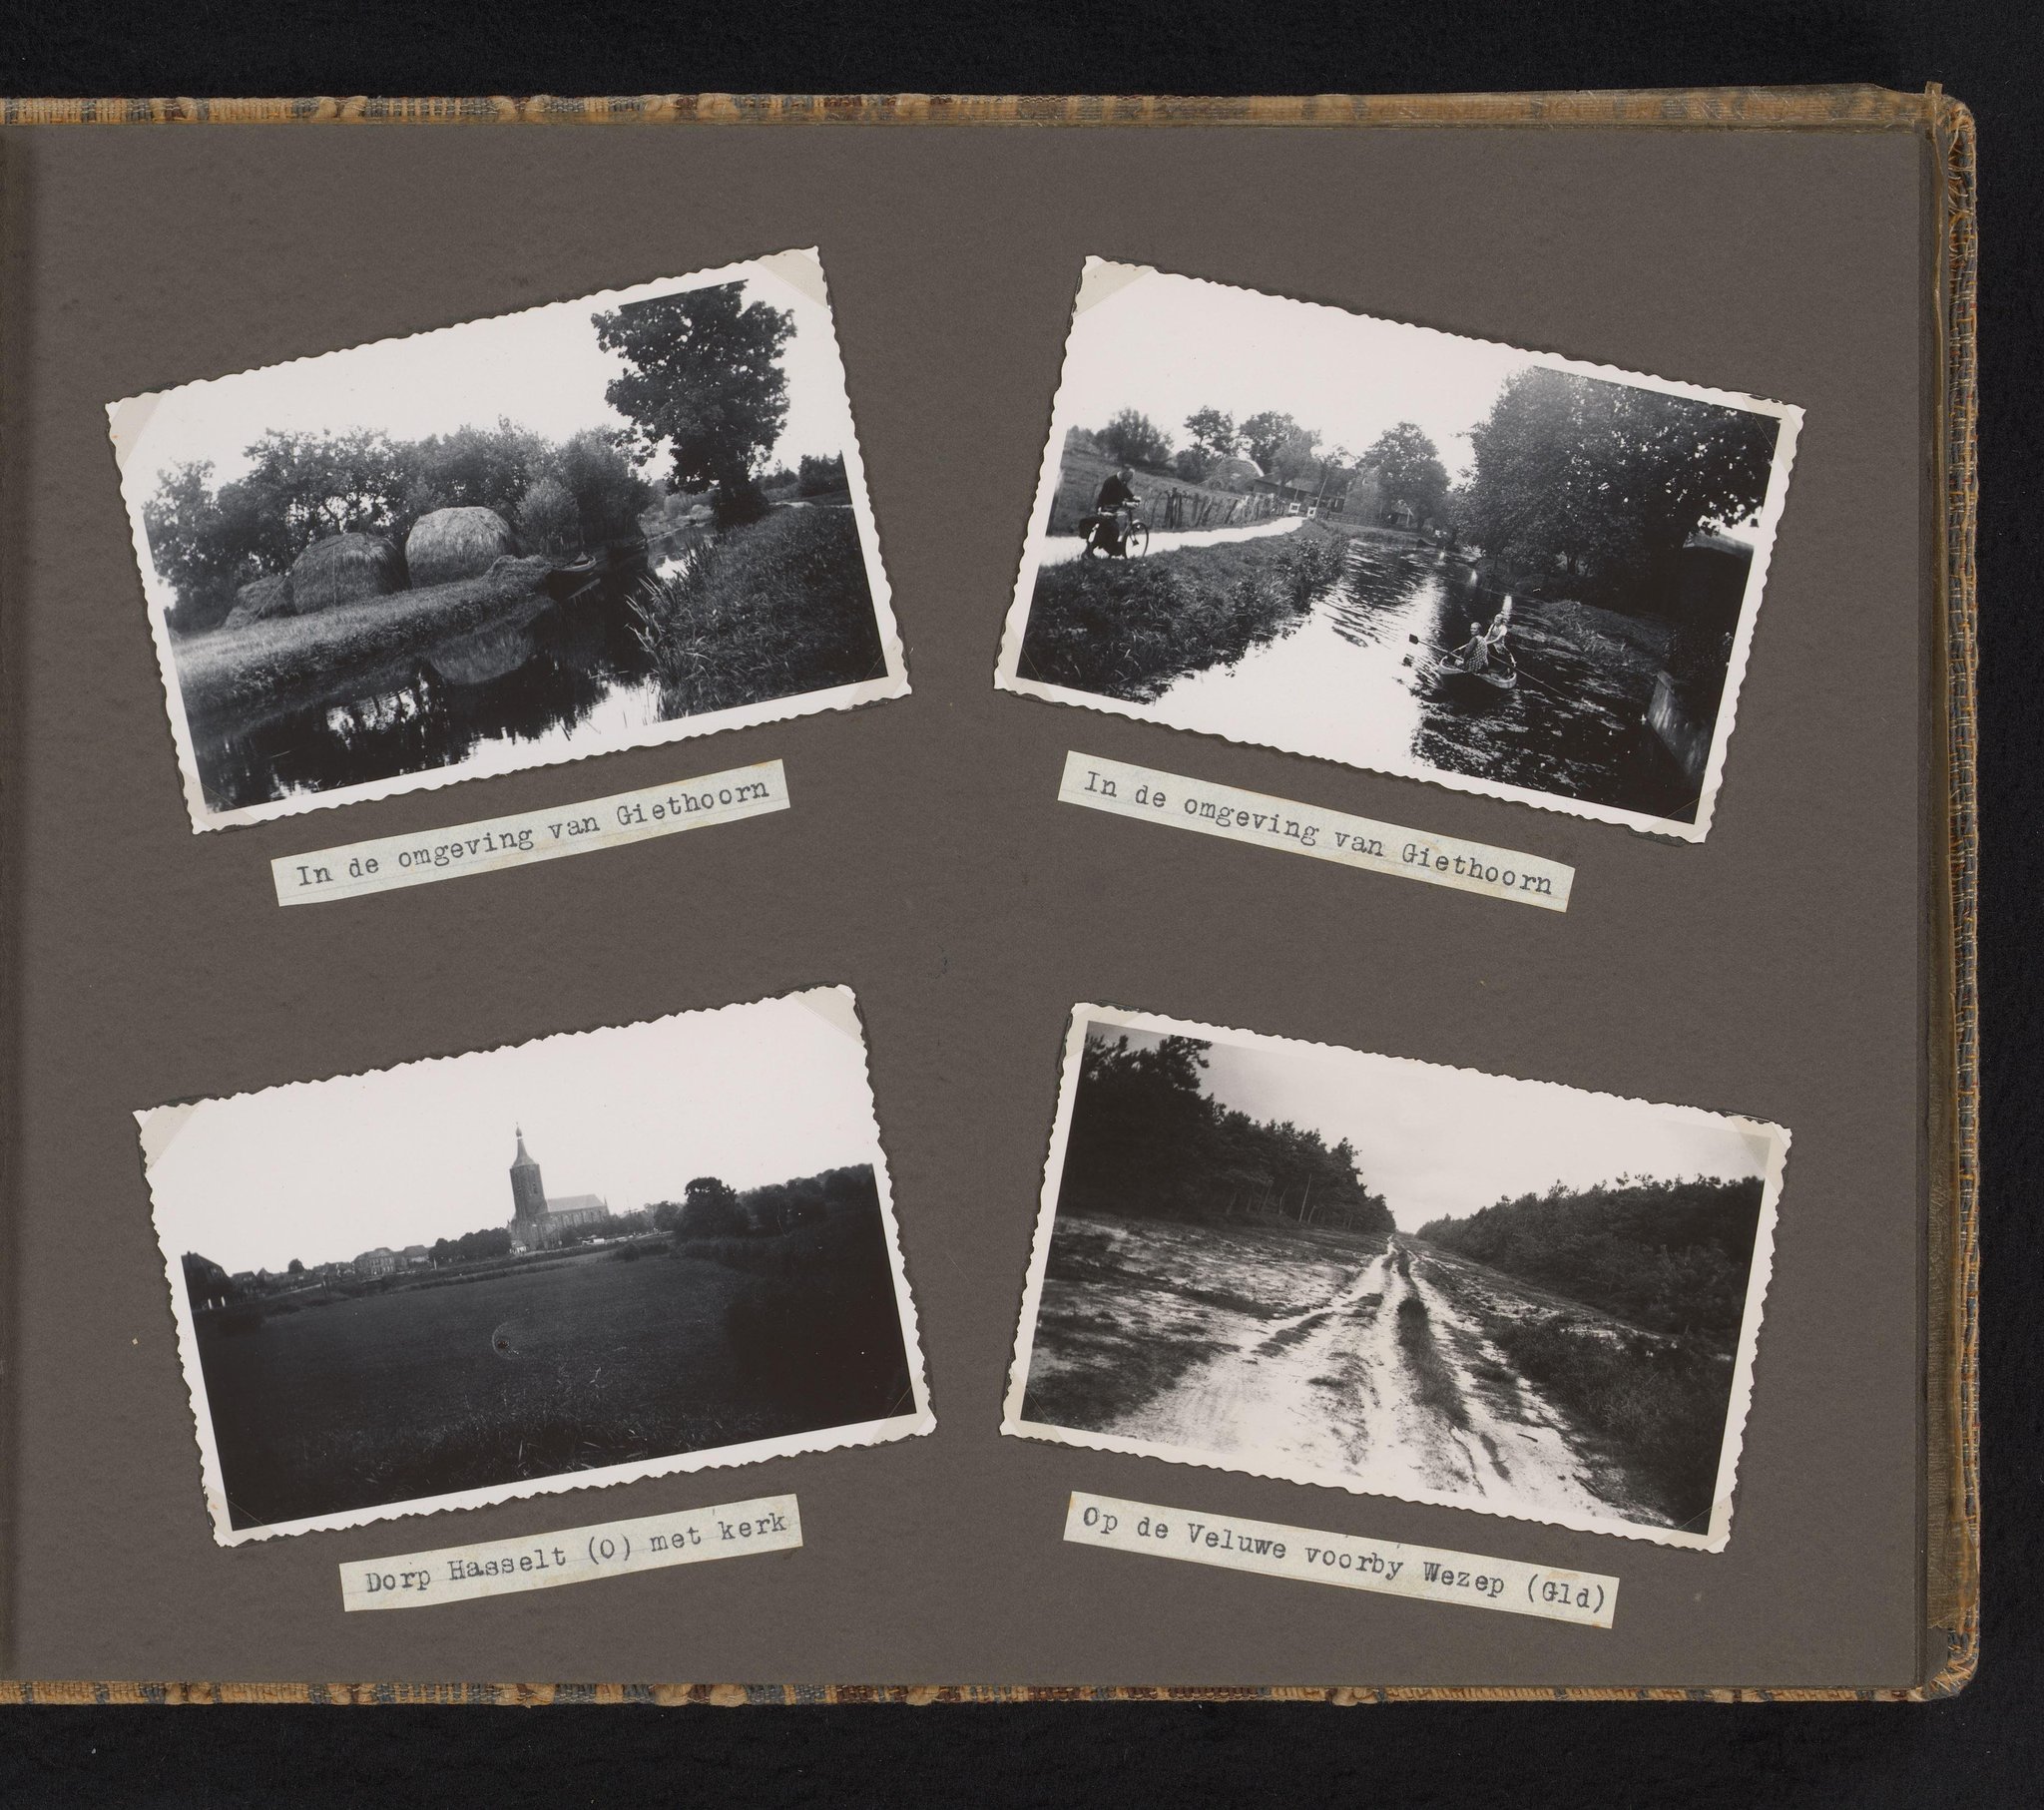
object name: photograph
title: Giethoorn en Hasselt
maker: Anonymous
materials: paper, photographic support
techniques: gelatin silver print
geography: netherlands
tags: riding, cycling (recreation), father with son(s) (father-love), outing, pleasure trip, bicycle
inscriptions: inscription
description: Albumblad met vier foto's in de omgeving van Giethoorn, Hasselt en Wezep. Onder de foto's uitgeknipte papiertjes met getypte opschriften. Onderdeel van het eerste fotoalbum met foto's van de twee fietstochten van vader en zoon door Nederland in september 1939 en juli 1940 en een autotrip met het gezin door Nederland, België en Luxemburg in juni 1949.